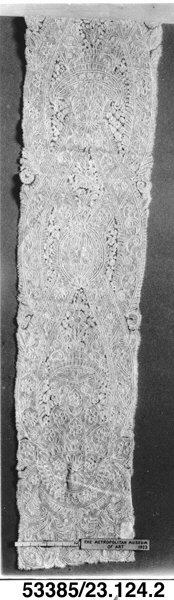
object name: lappet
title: Lappet (one of a pair)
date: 1701-1733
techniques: lace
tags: flowers